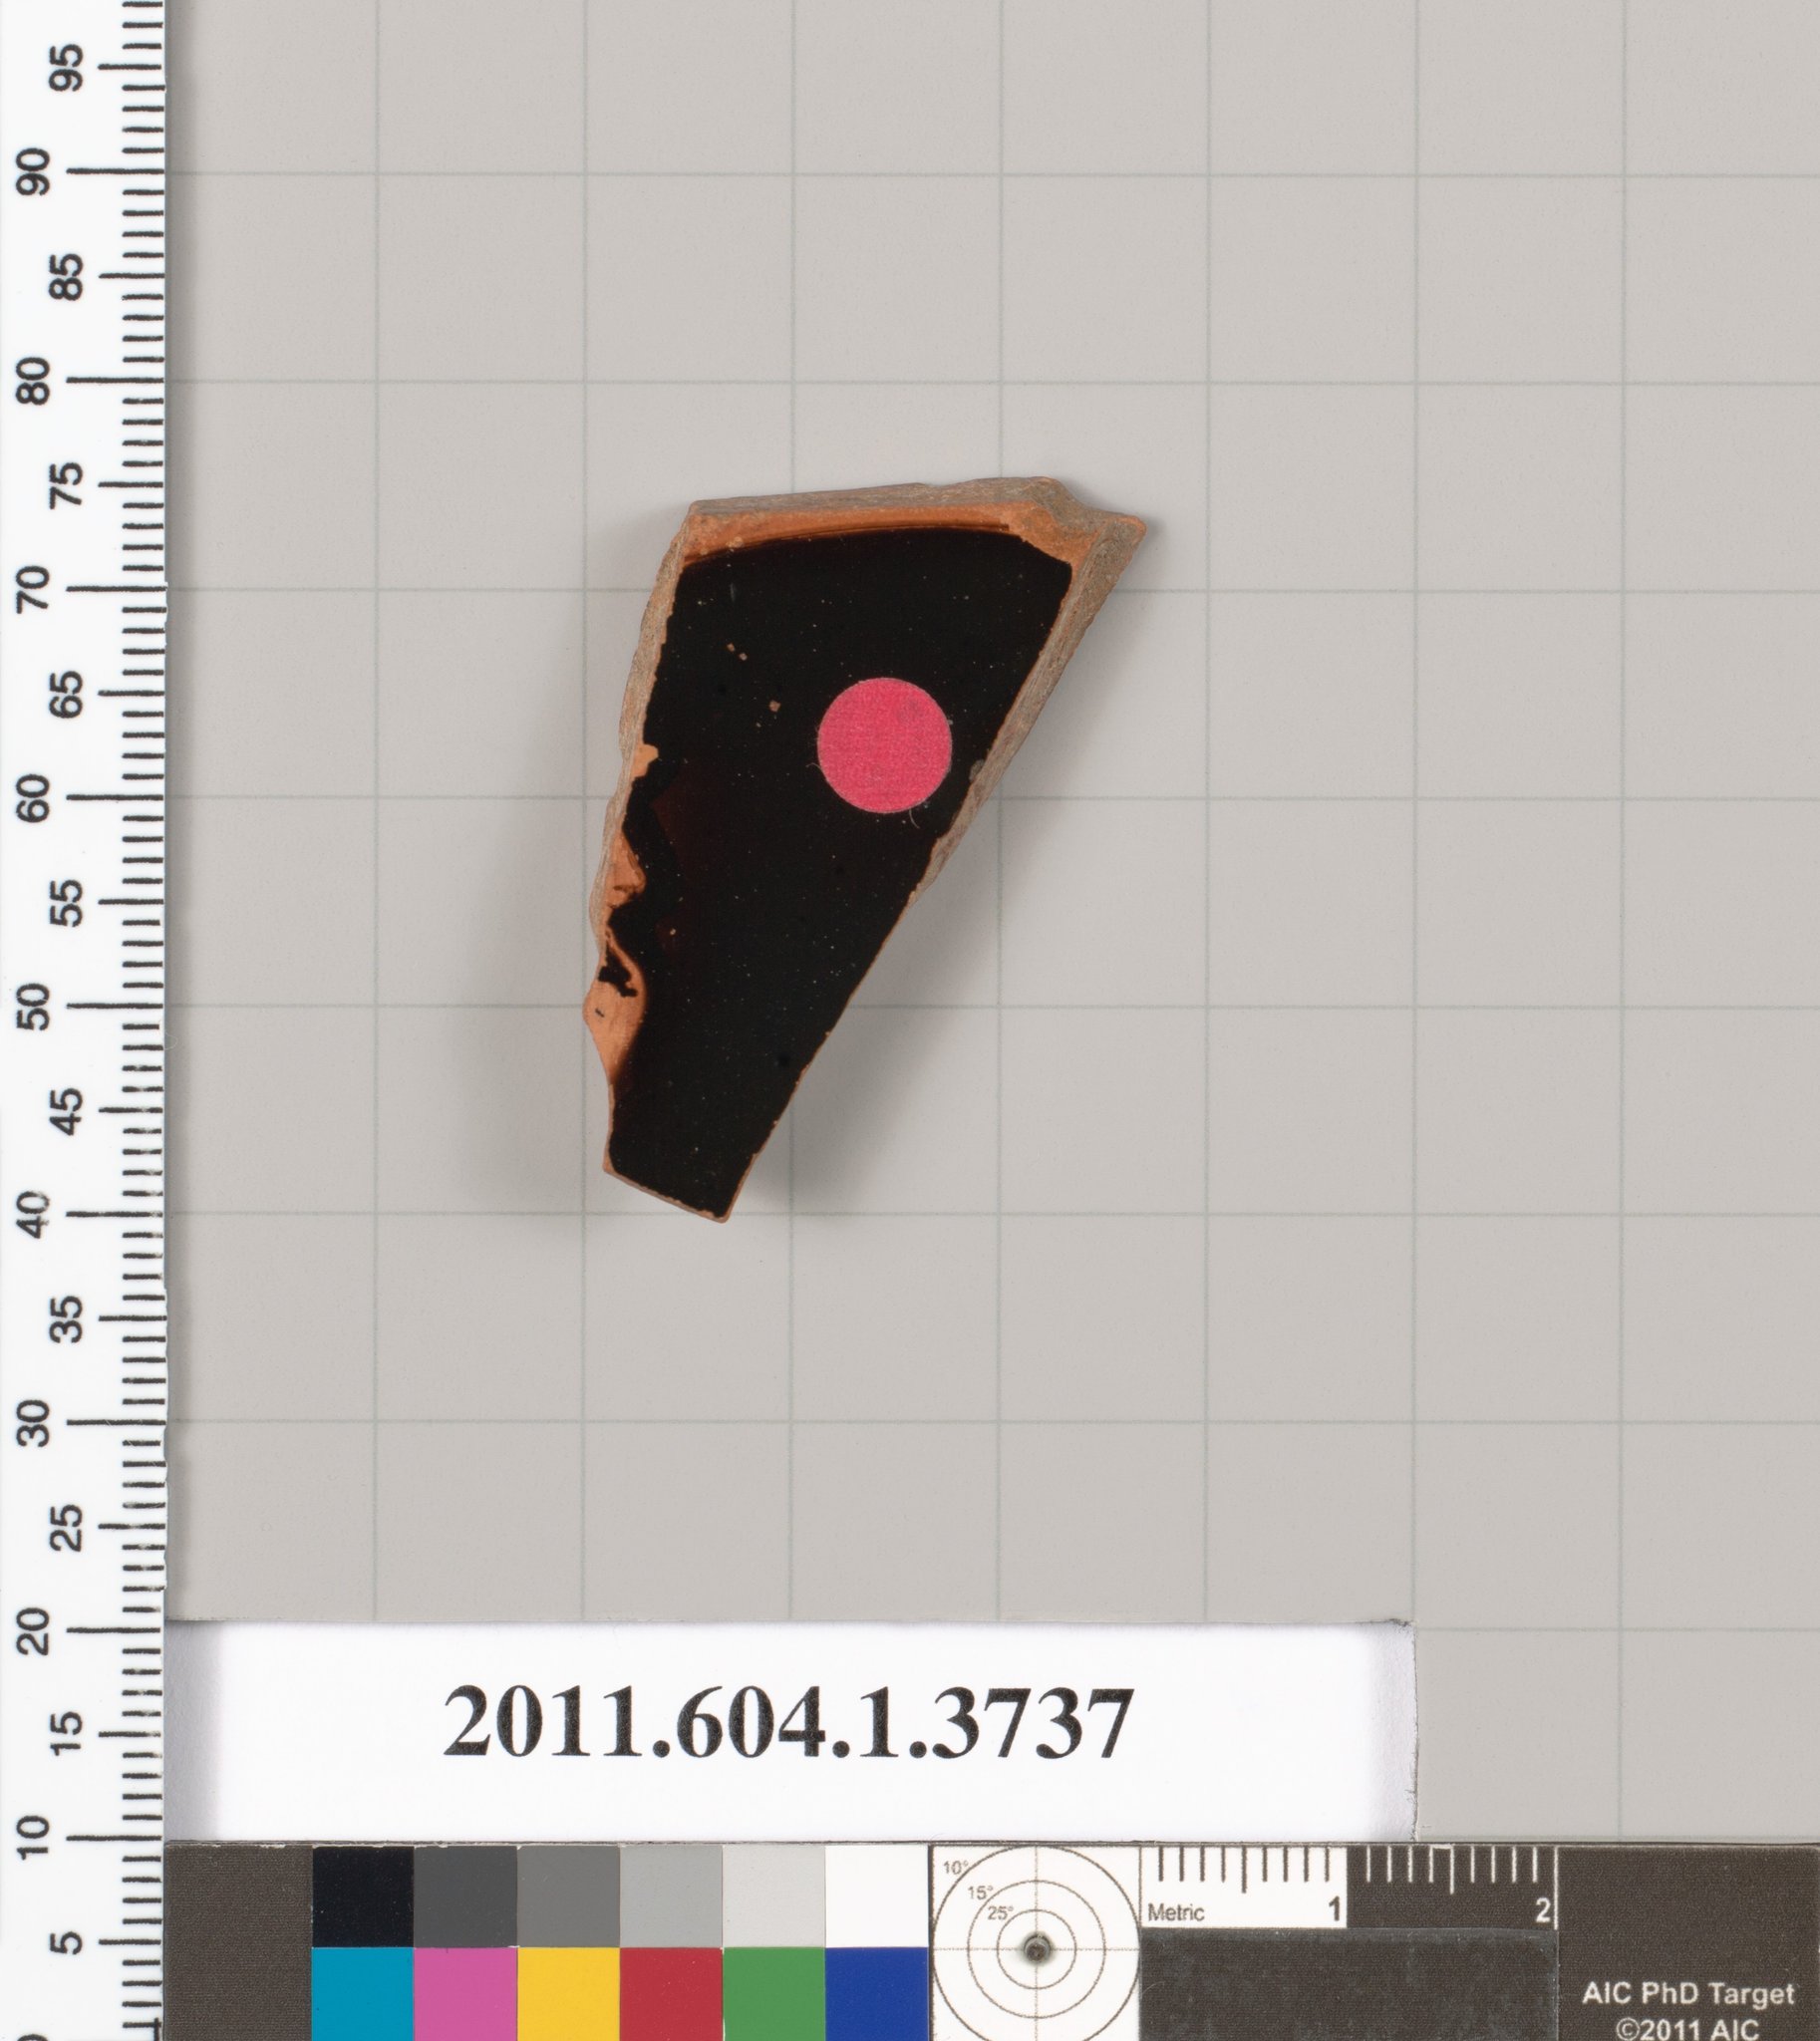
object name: kylix fragment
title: Terracotta fragment of a kylix (drinking cup)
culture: greek, attic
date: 401-450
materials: terracotta